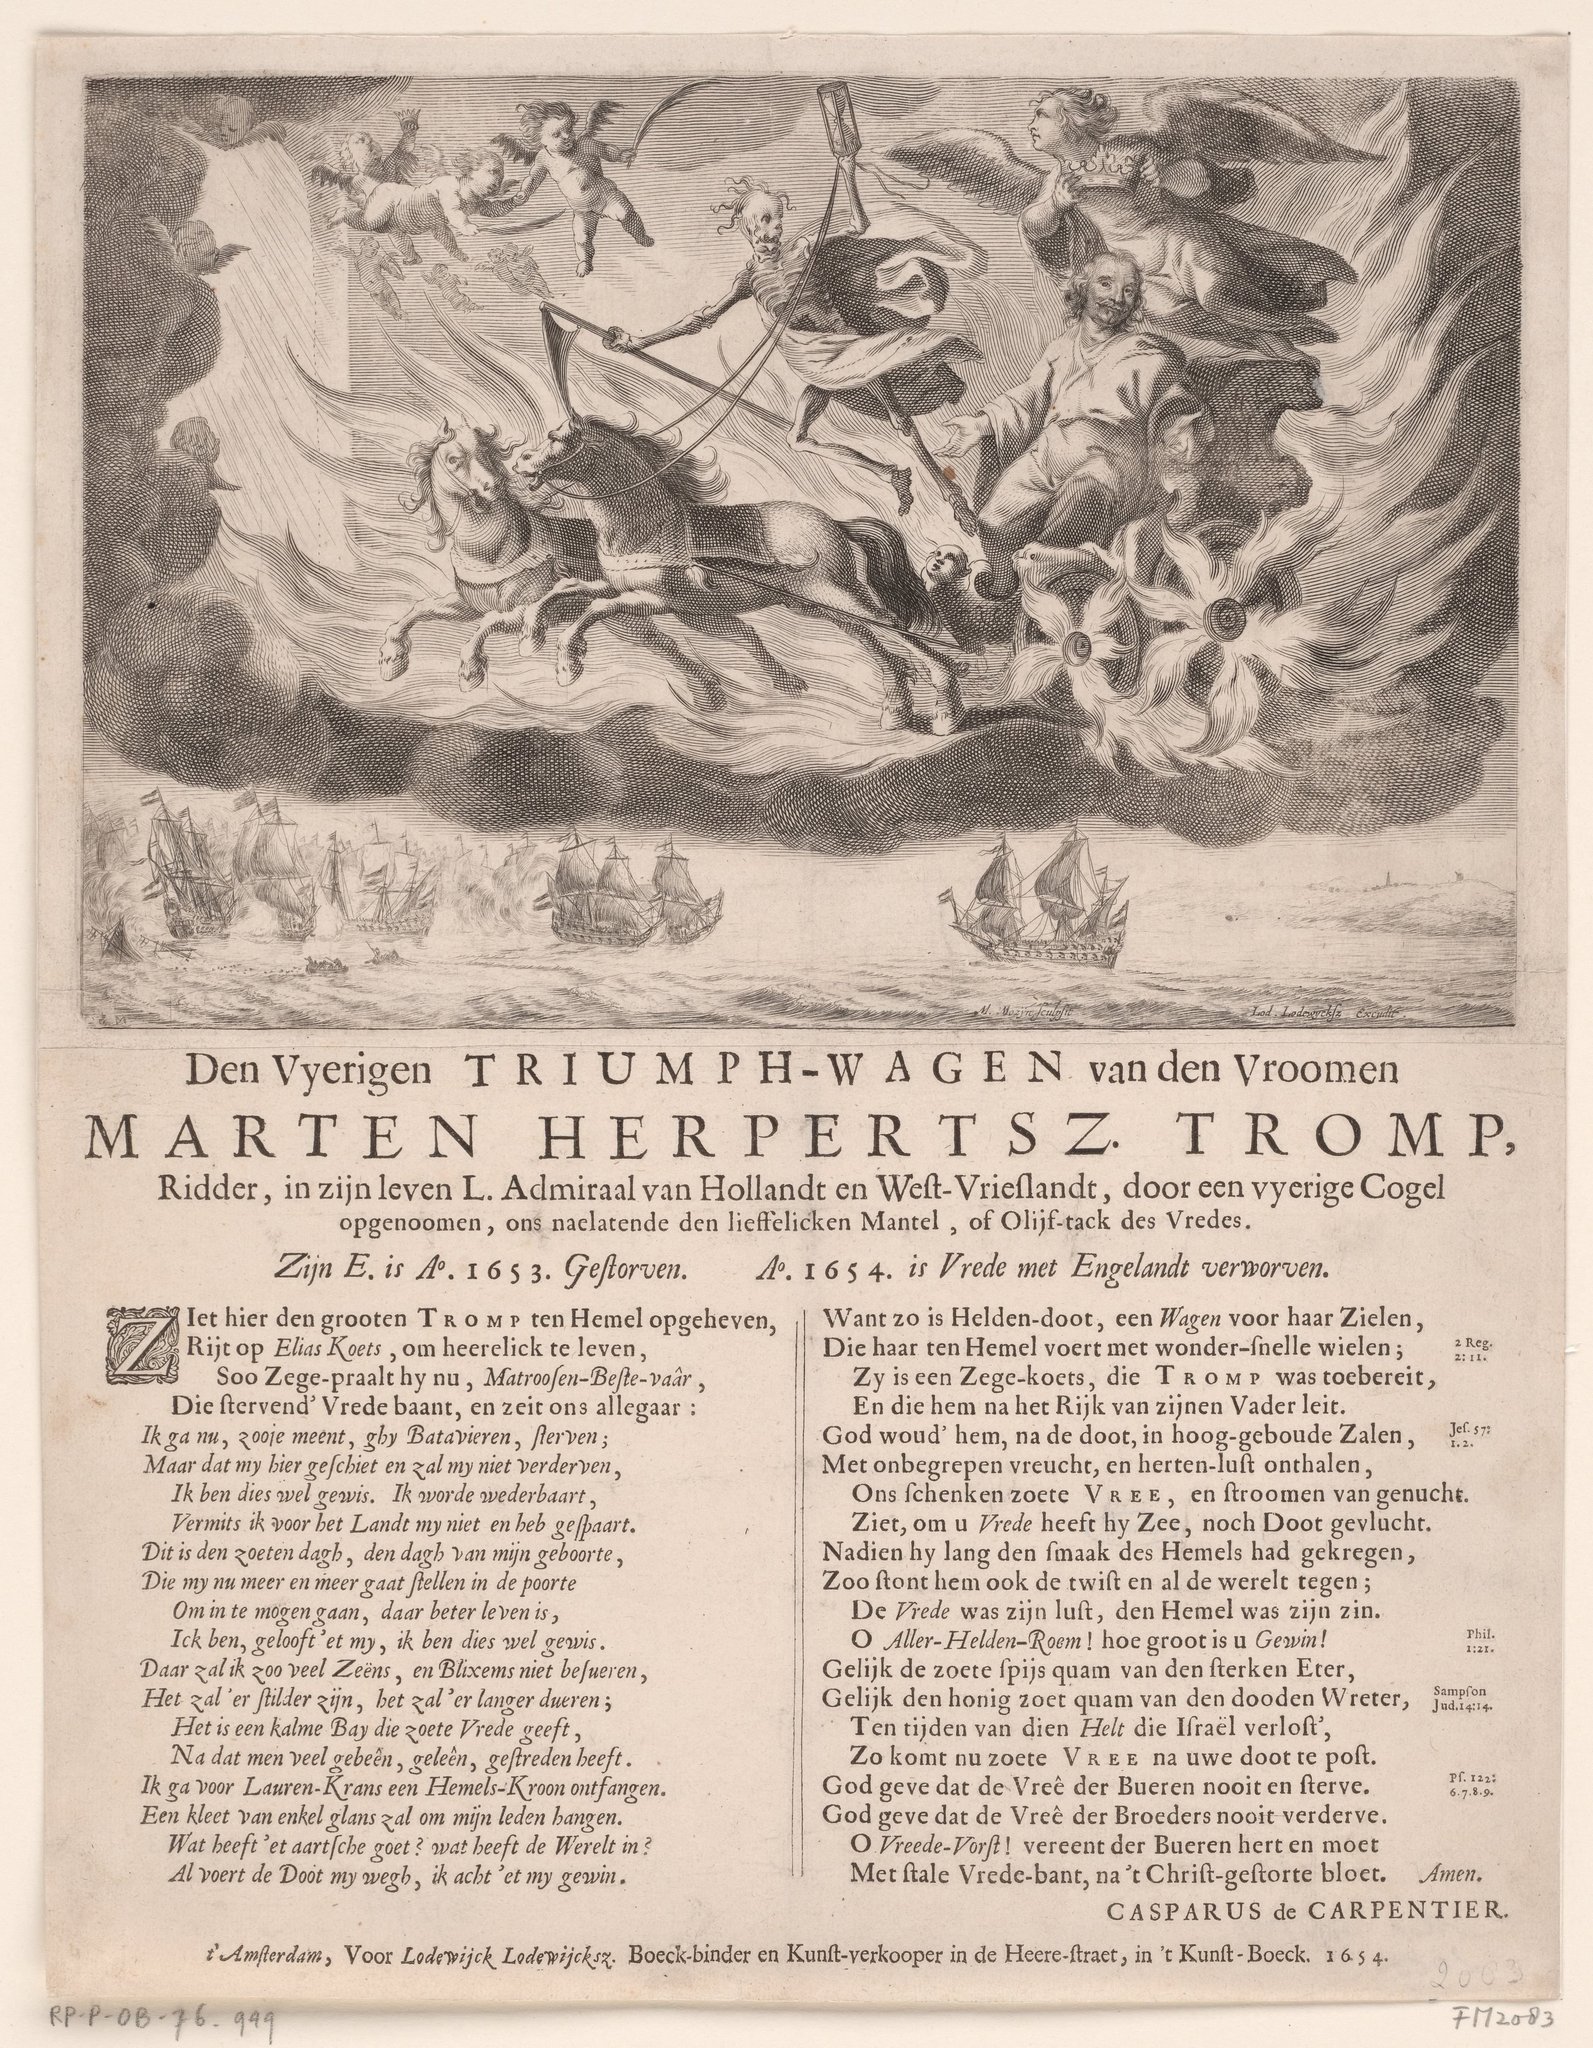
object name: propagandaprent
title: Apotheose van Maarten Tromp, 1653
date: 1654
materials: paper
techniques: engraving, etching, letterpress printing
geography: northern netherlands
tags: brielle, maarten harpertszoon tromp, apotheosis (or ascension) of individuals, battle of scheveningen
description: Apotheose van Maarten Tromp, gedood op 10 augustus 1653 tijdens de zeeslag bij Terheide. De admiraal gezeten in een vurige strijdwagen, gemend door de Dood, boven zee waar het gevecht plaatsvindt. Onder de prent is een blad vastgeplakt met een vers gedrukt in twee kolommen over de dood van tromp in 1653 en de vrede gesloten met Engeland in 1654.